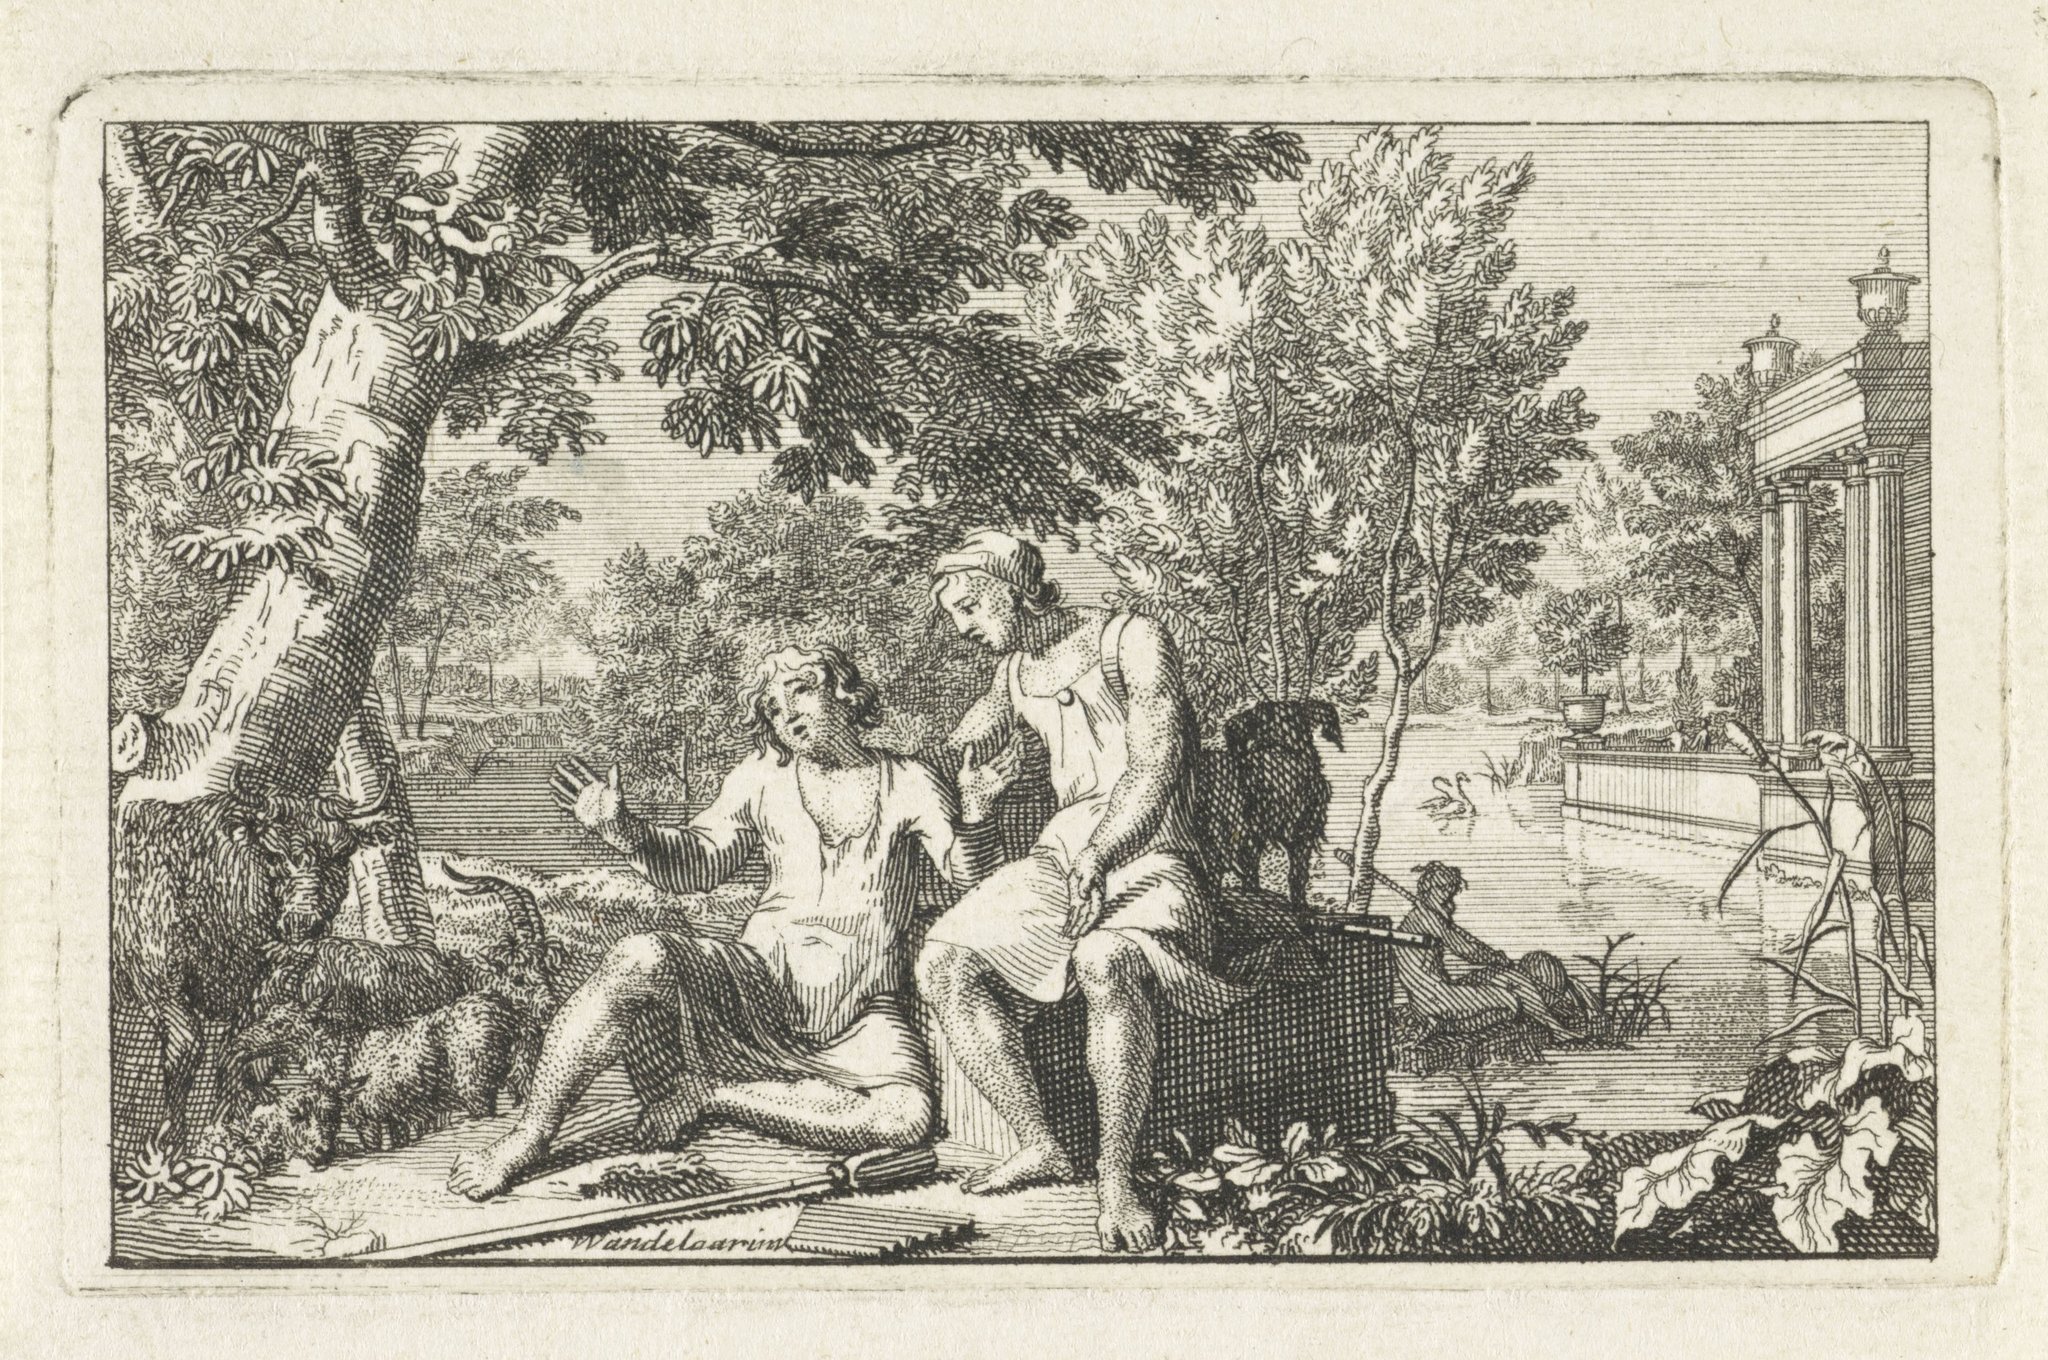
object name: print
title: Twee herders bij een waterpartij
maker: jan wandelaar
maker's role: draughtsman, print maker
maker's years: 1690-1759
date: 1710-1759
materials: paper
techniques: etching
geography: northern netherlands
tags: panpipes - cc - out of doors, herding, herdsman, herdswoman, shepherd, shepherdess, cowherd, etc., cattle, lake, dog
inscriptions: collector's mark: Lugt 240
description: Bij een boom zitten twee herders en een hond. Voor hen ligt een panfluit naast een staf op de grond. Onder de boom verschillende dieren. Achter hen is een waterpartij te zien. Rechts staat een gebouw met zuilen.